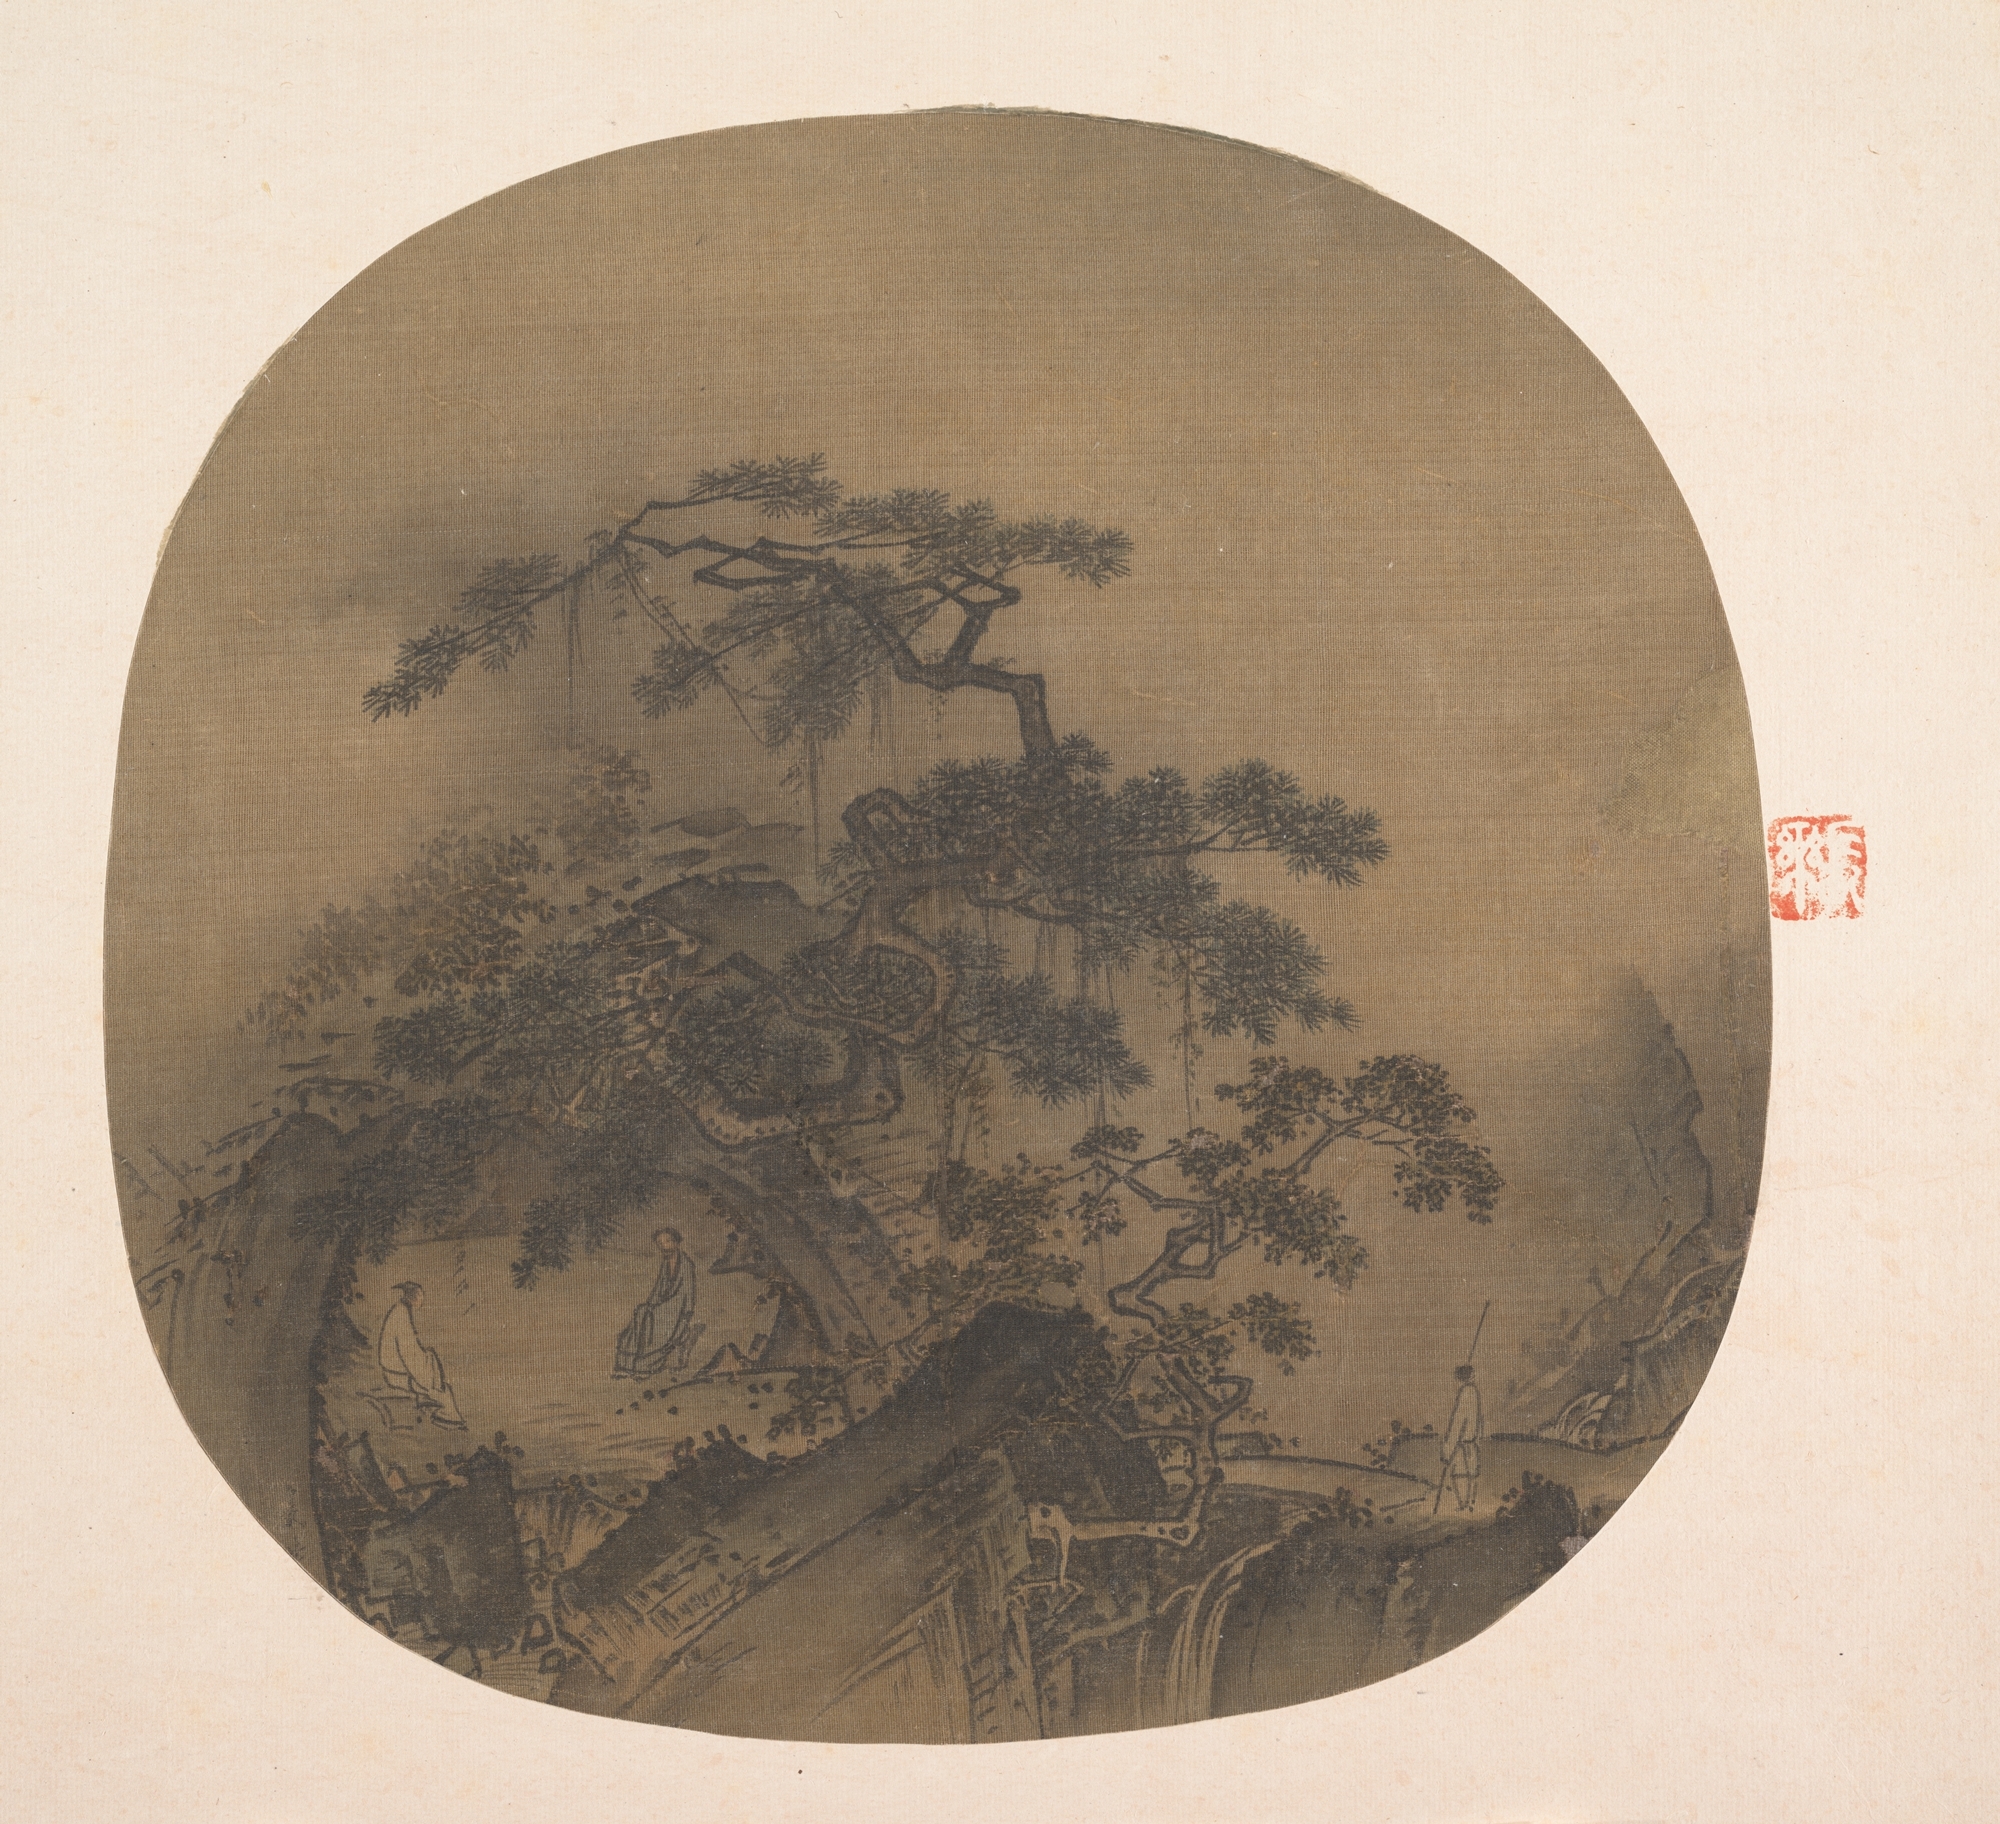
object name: fan mounted a an album leaf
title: Conversation in a cave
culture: chinese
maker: unidentified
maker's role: artist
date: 1201-1300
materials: ink, silk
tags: men,caves,trees